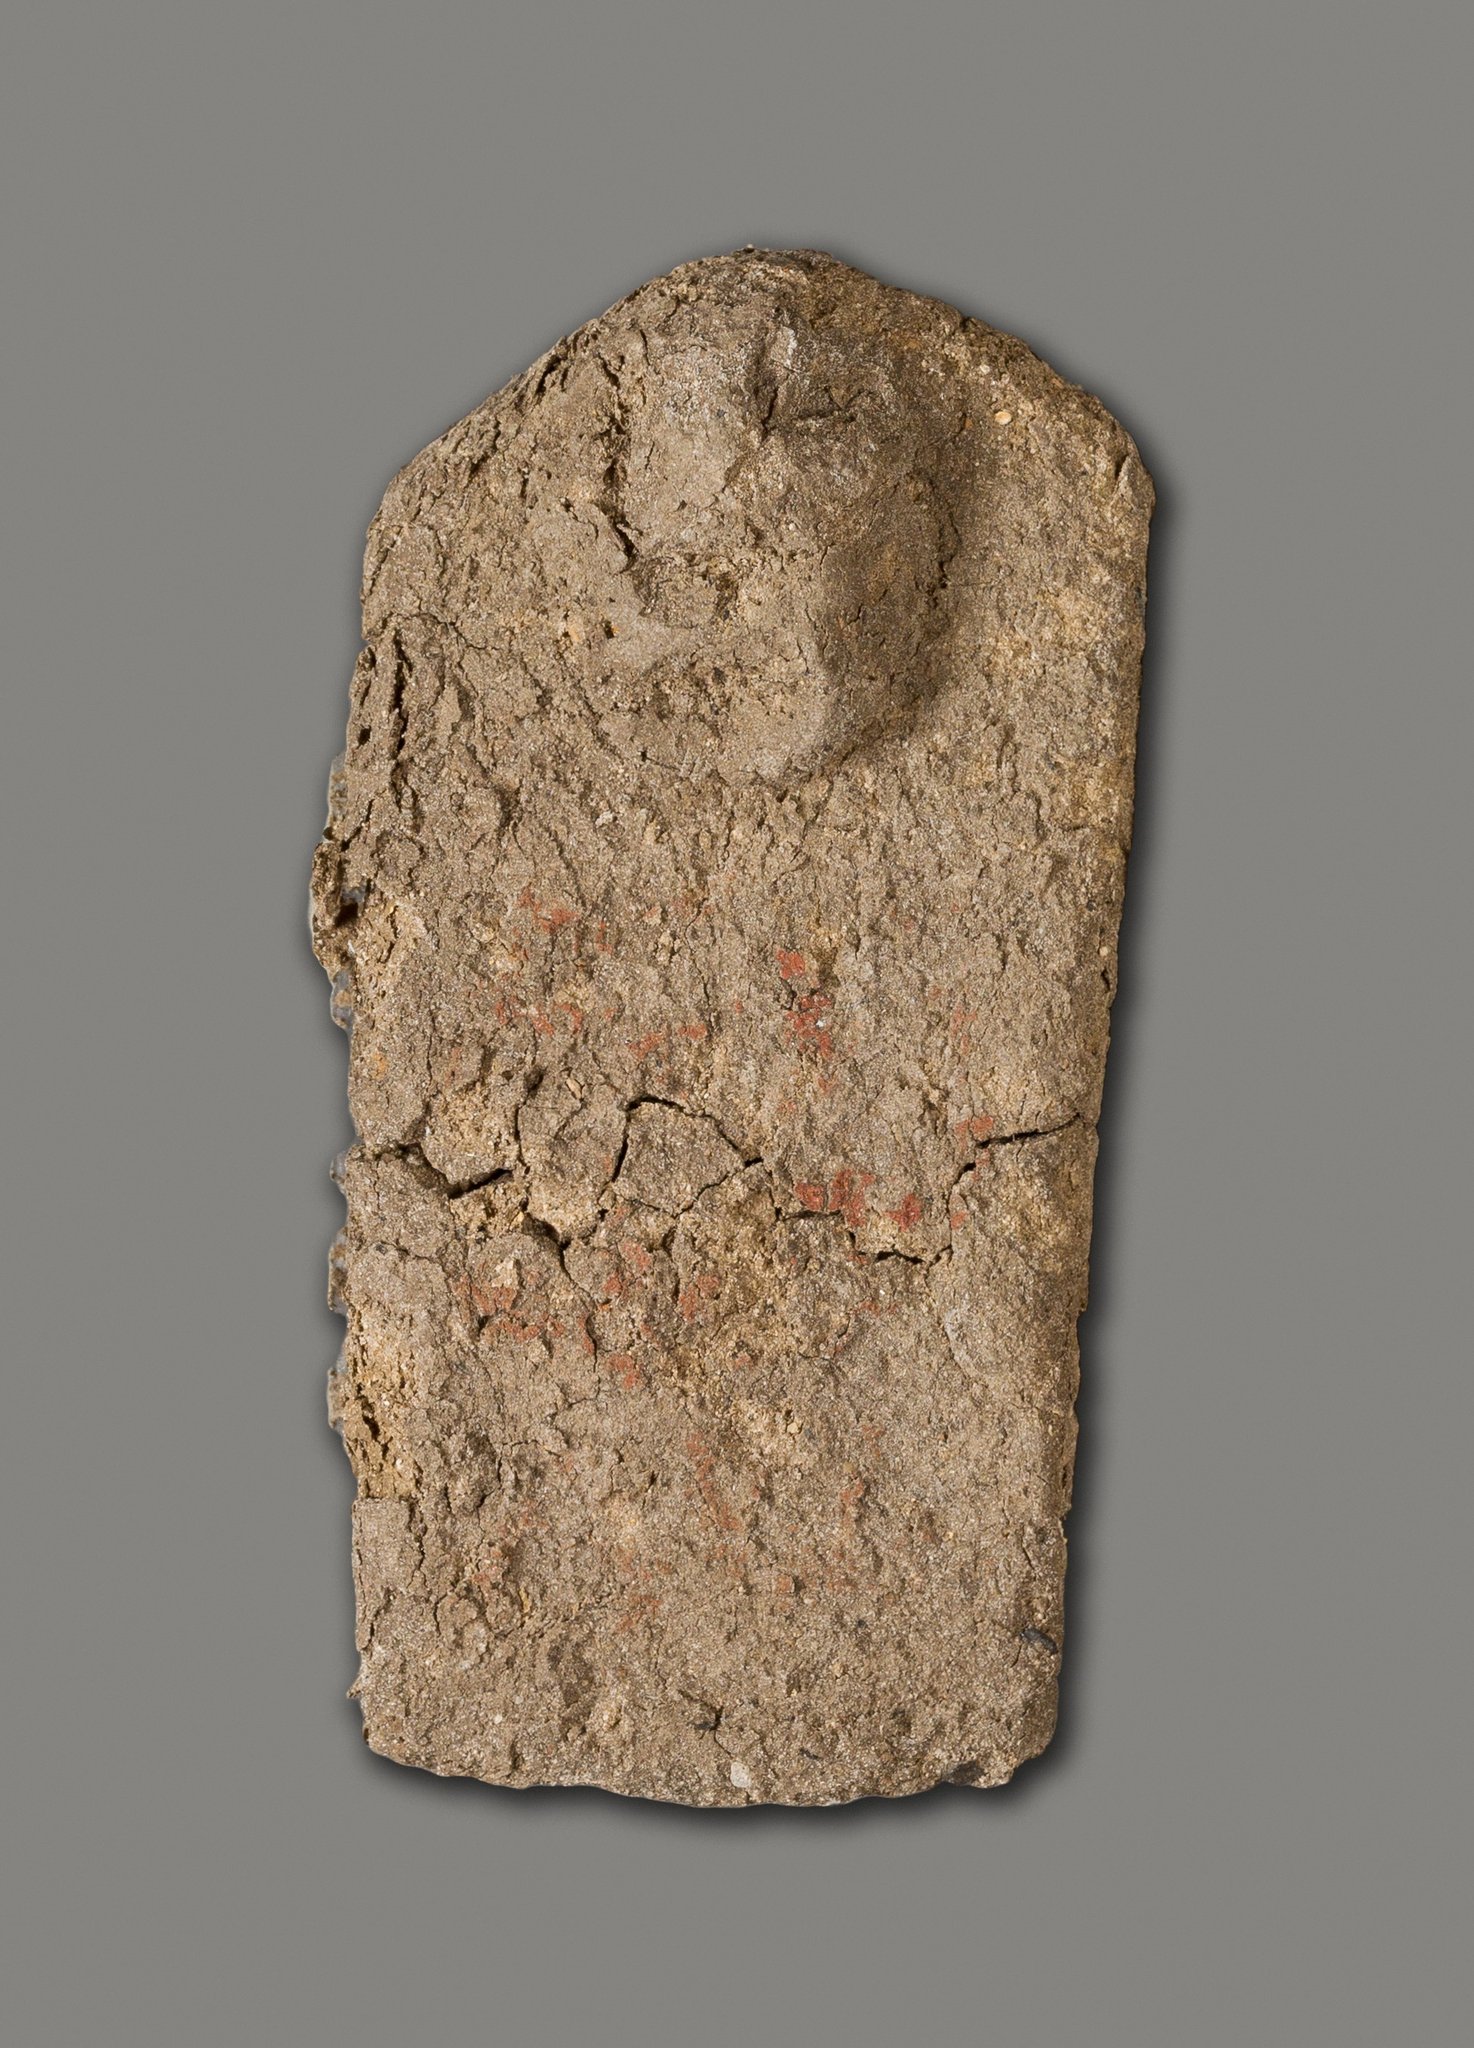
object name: figure, magical, execration, tablet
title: Magical Figure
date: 1802-1550 BCE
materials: clay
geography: egypt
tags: faces